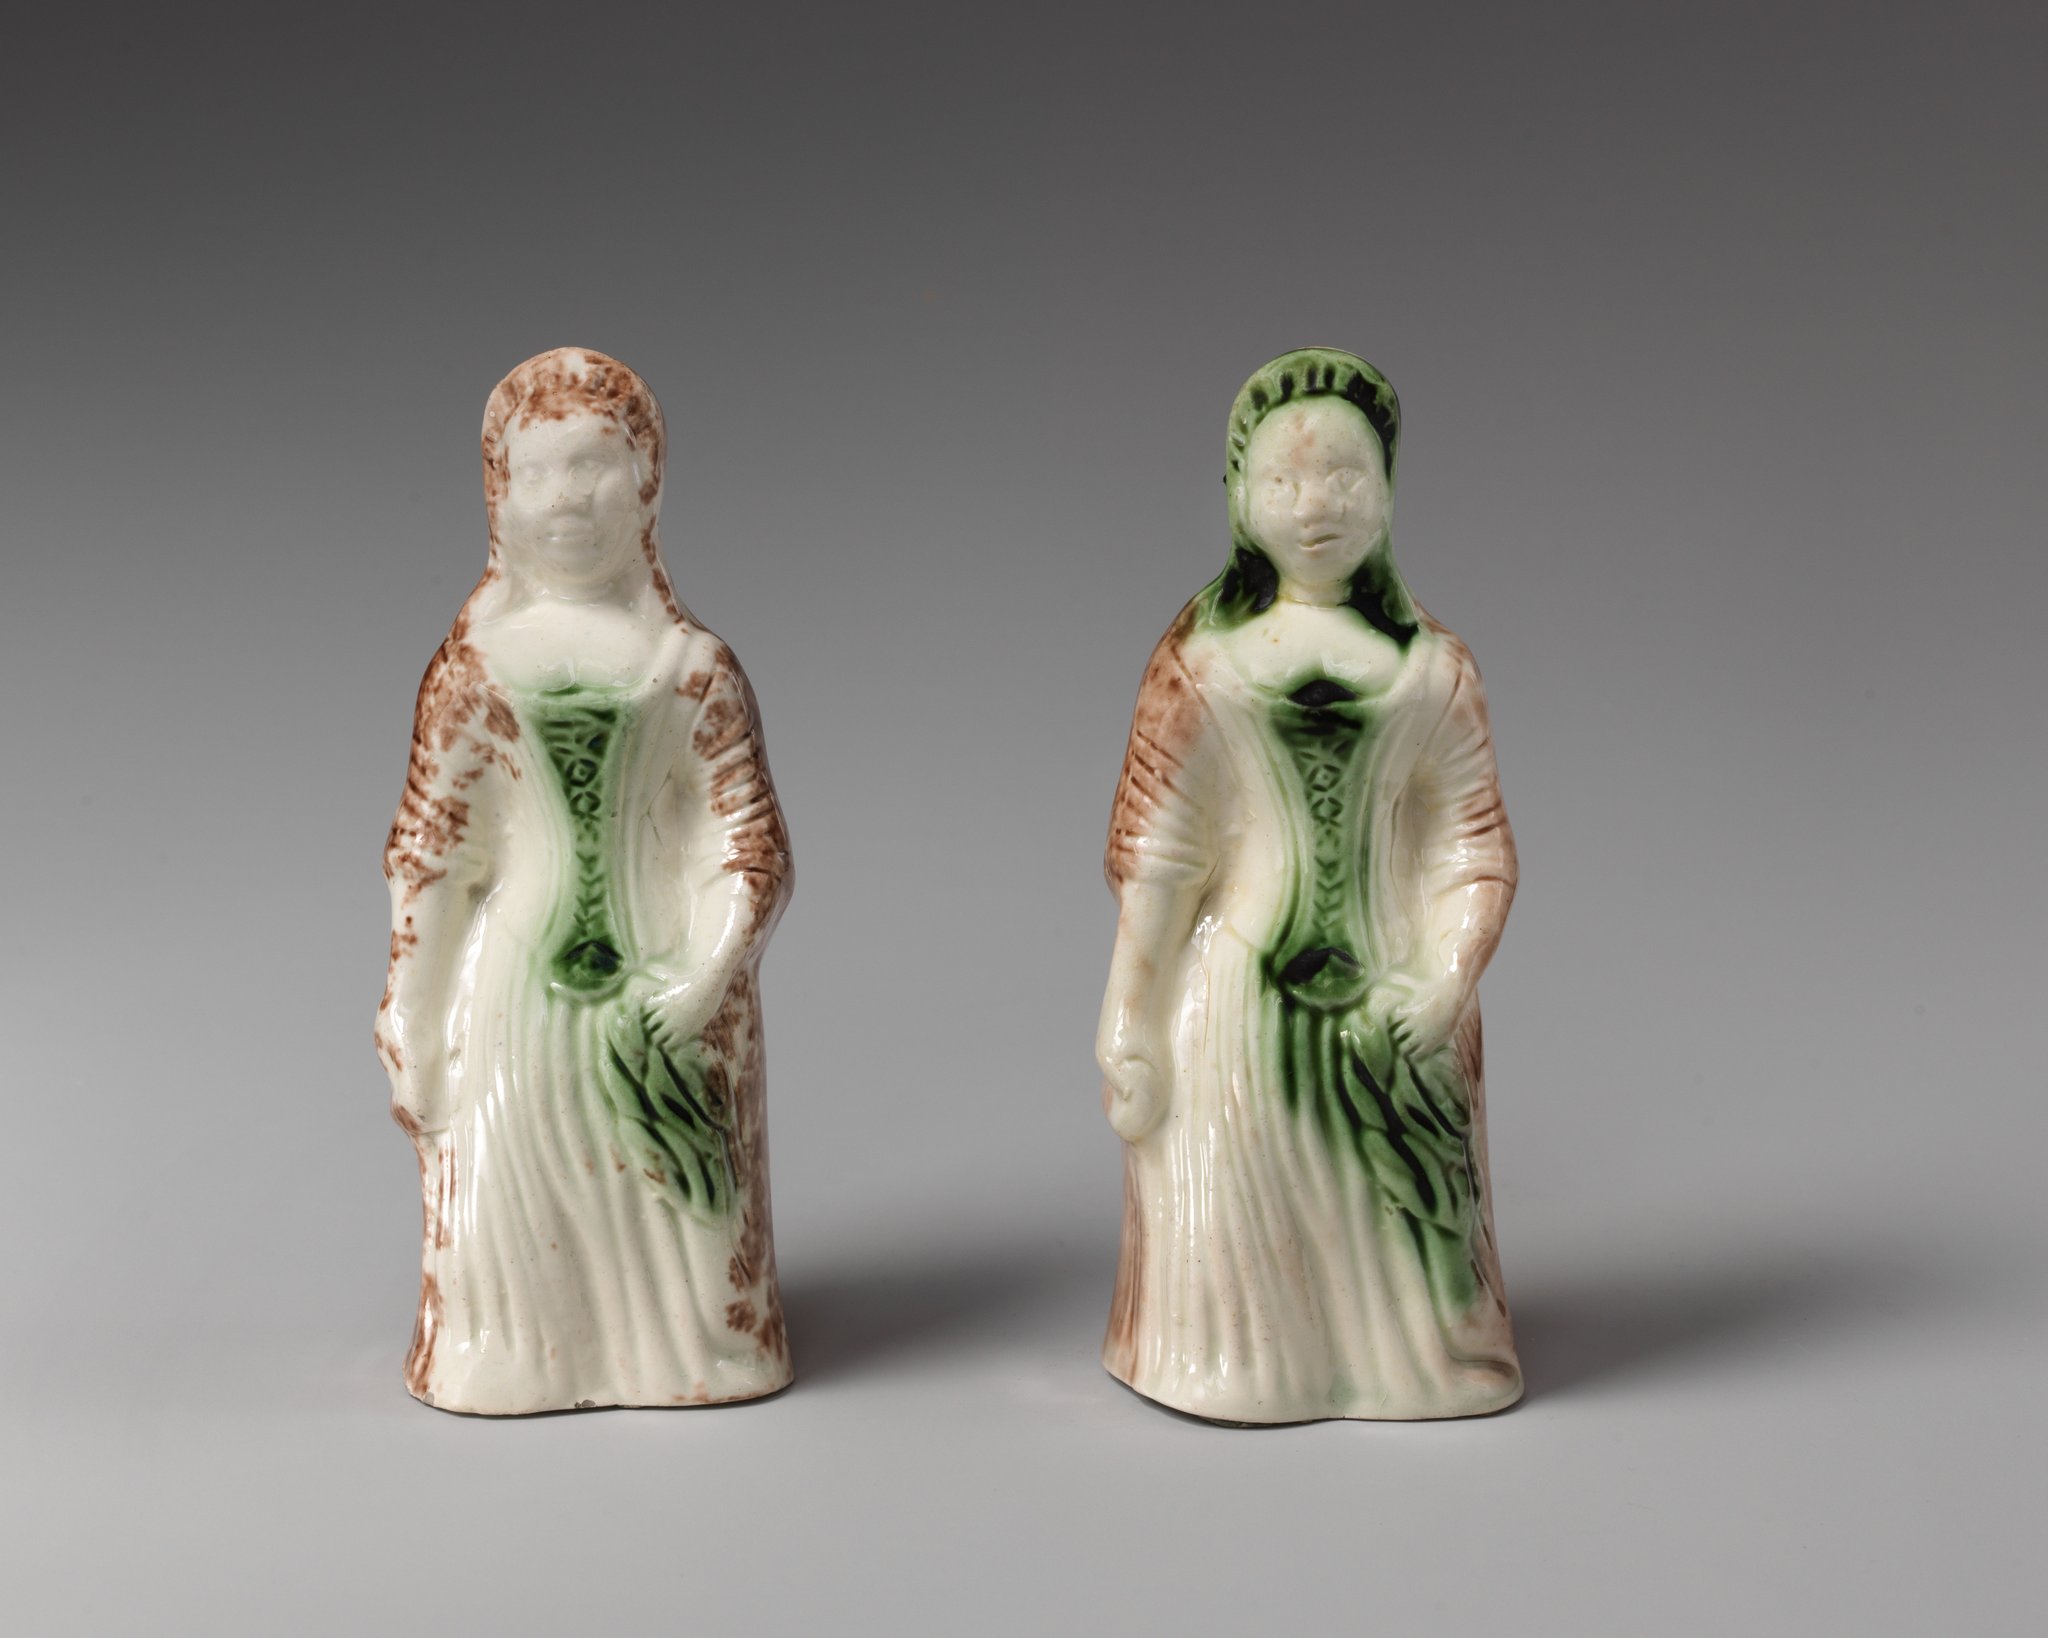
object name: figure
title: Pair of standing women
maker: whieldon type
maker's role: maker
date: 1750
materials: earthenware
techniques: glazing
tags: women